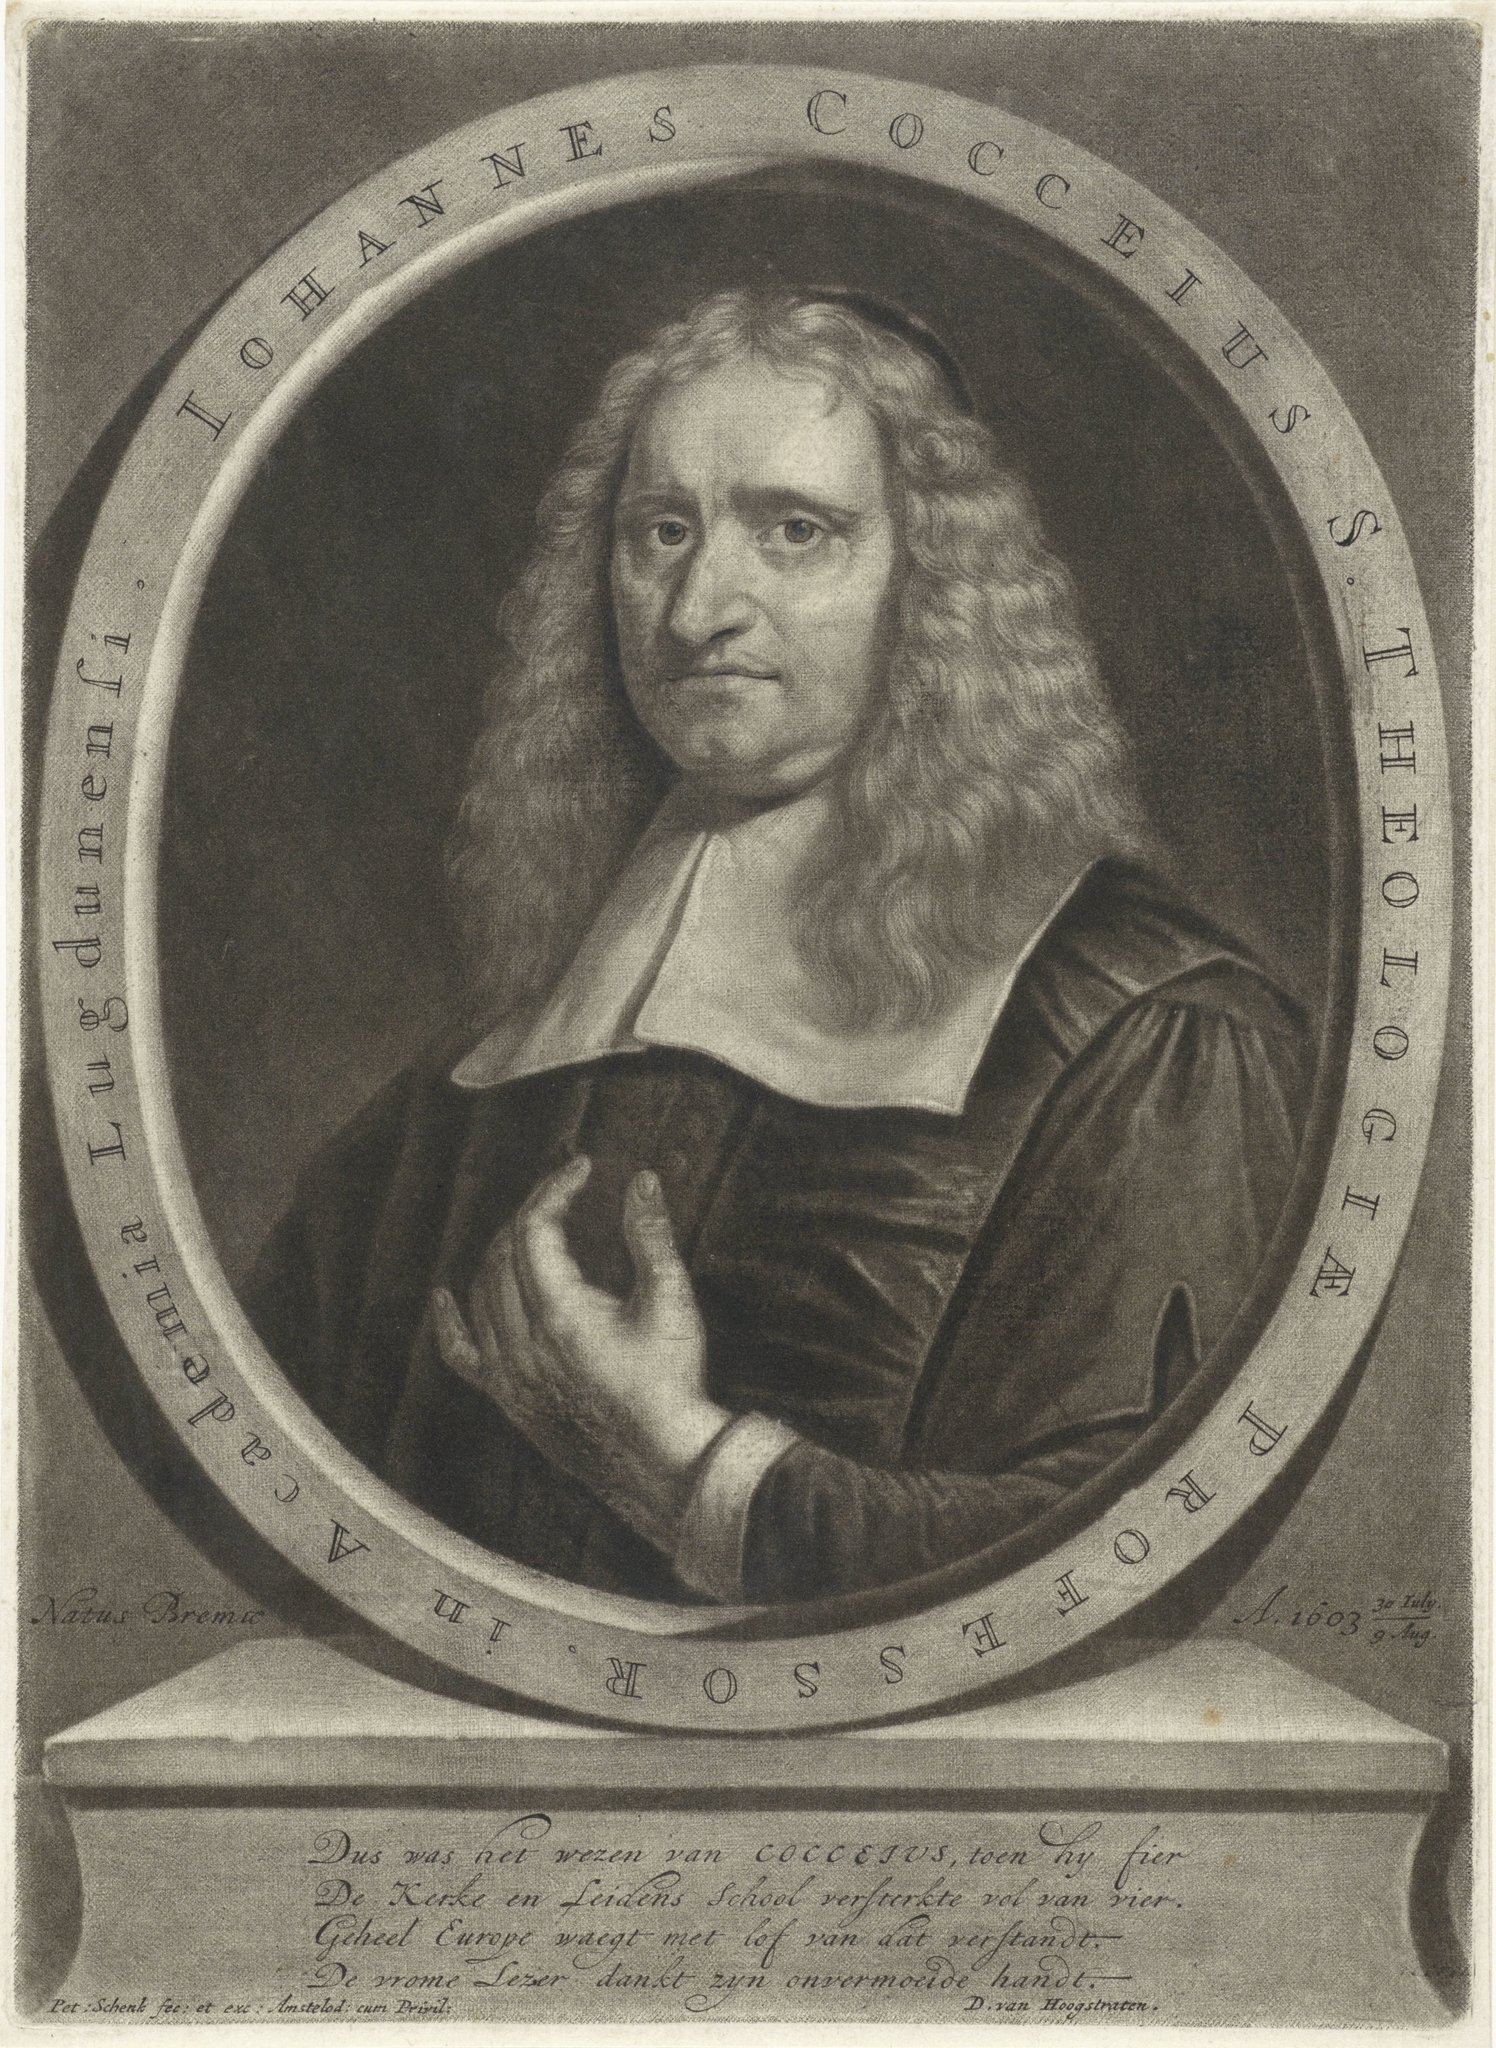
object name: print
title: Portret van Johannes Cocceius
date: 1670-1713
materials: paper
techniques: engraving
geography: amsterdam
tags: hoogleraar, johannes cocceius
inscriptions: collector's mark: Lugt 2228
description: Johannes Coch (Cocceius), Duits-Nederlands theoloog, filoloog en hoogleraar in achtereenvolgens Bremen, Franeker en Leiden. Hij houdt zijn hand voor zijn borst.